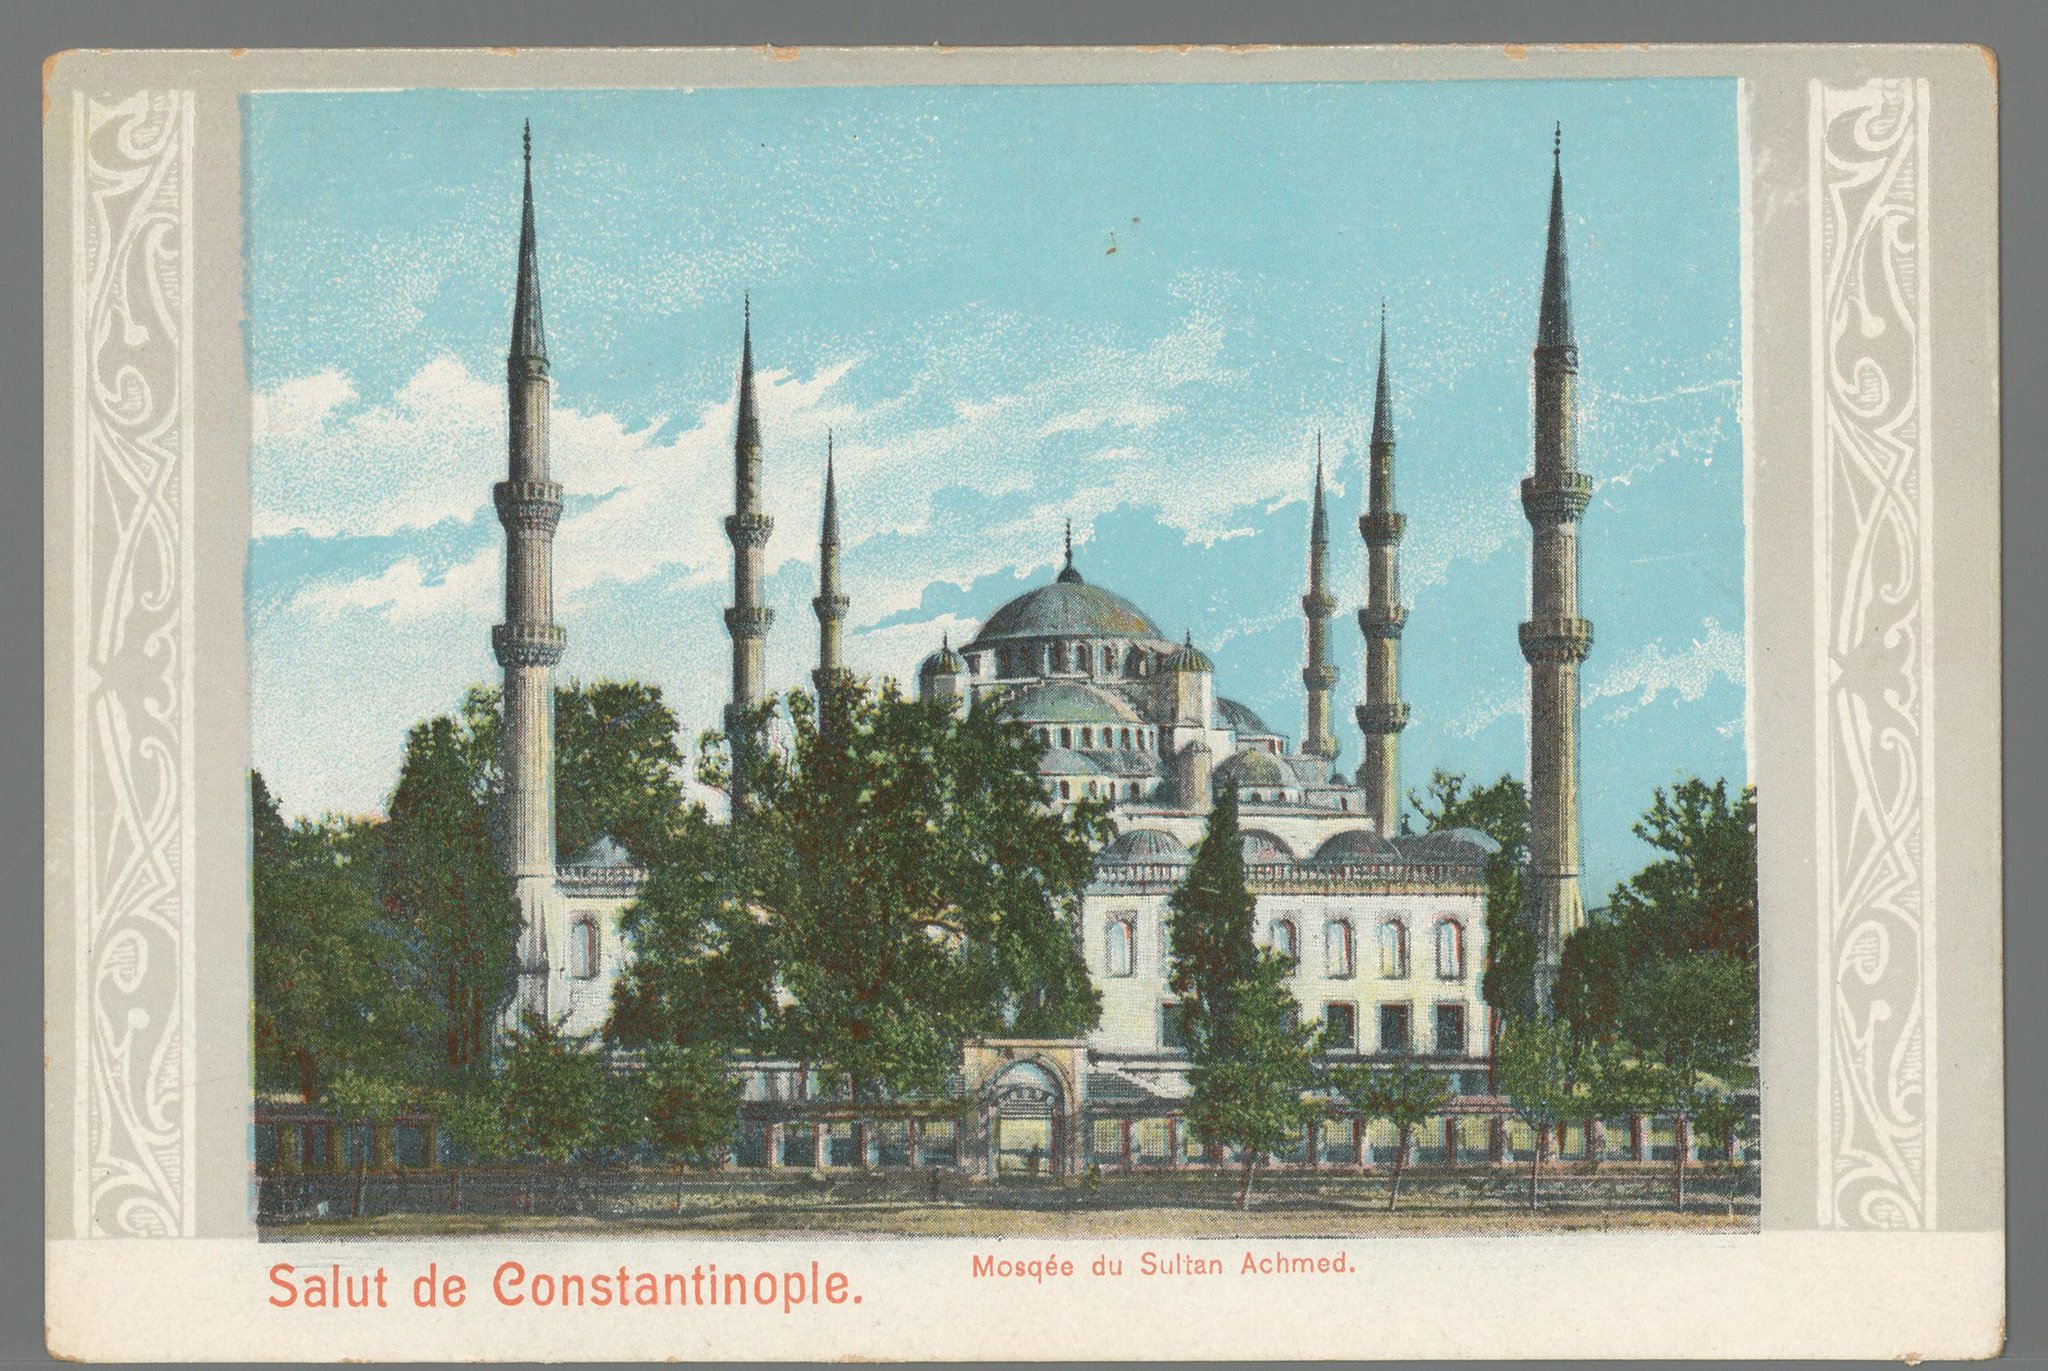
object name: ansichtkaart, prentbriefkaart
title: Mosqée du Sultan Achmed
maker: Anonymous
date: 1906-1920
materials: cardboard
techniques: lithograph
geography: constantinople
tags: temple, shrine ~ islam, mohammedanism